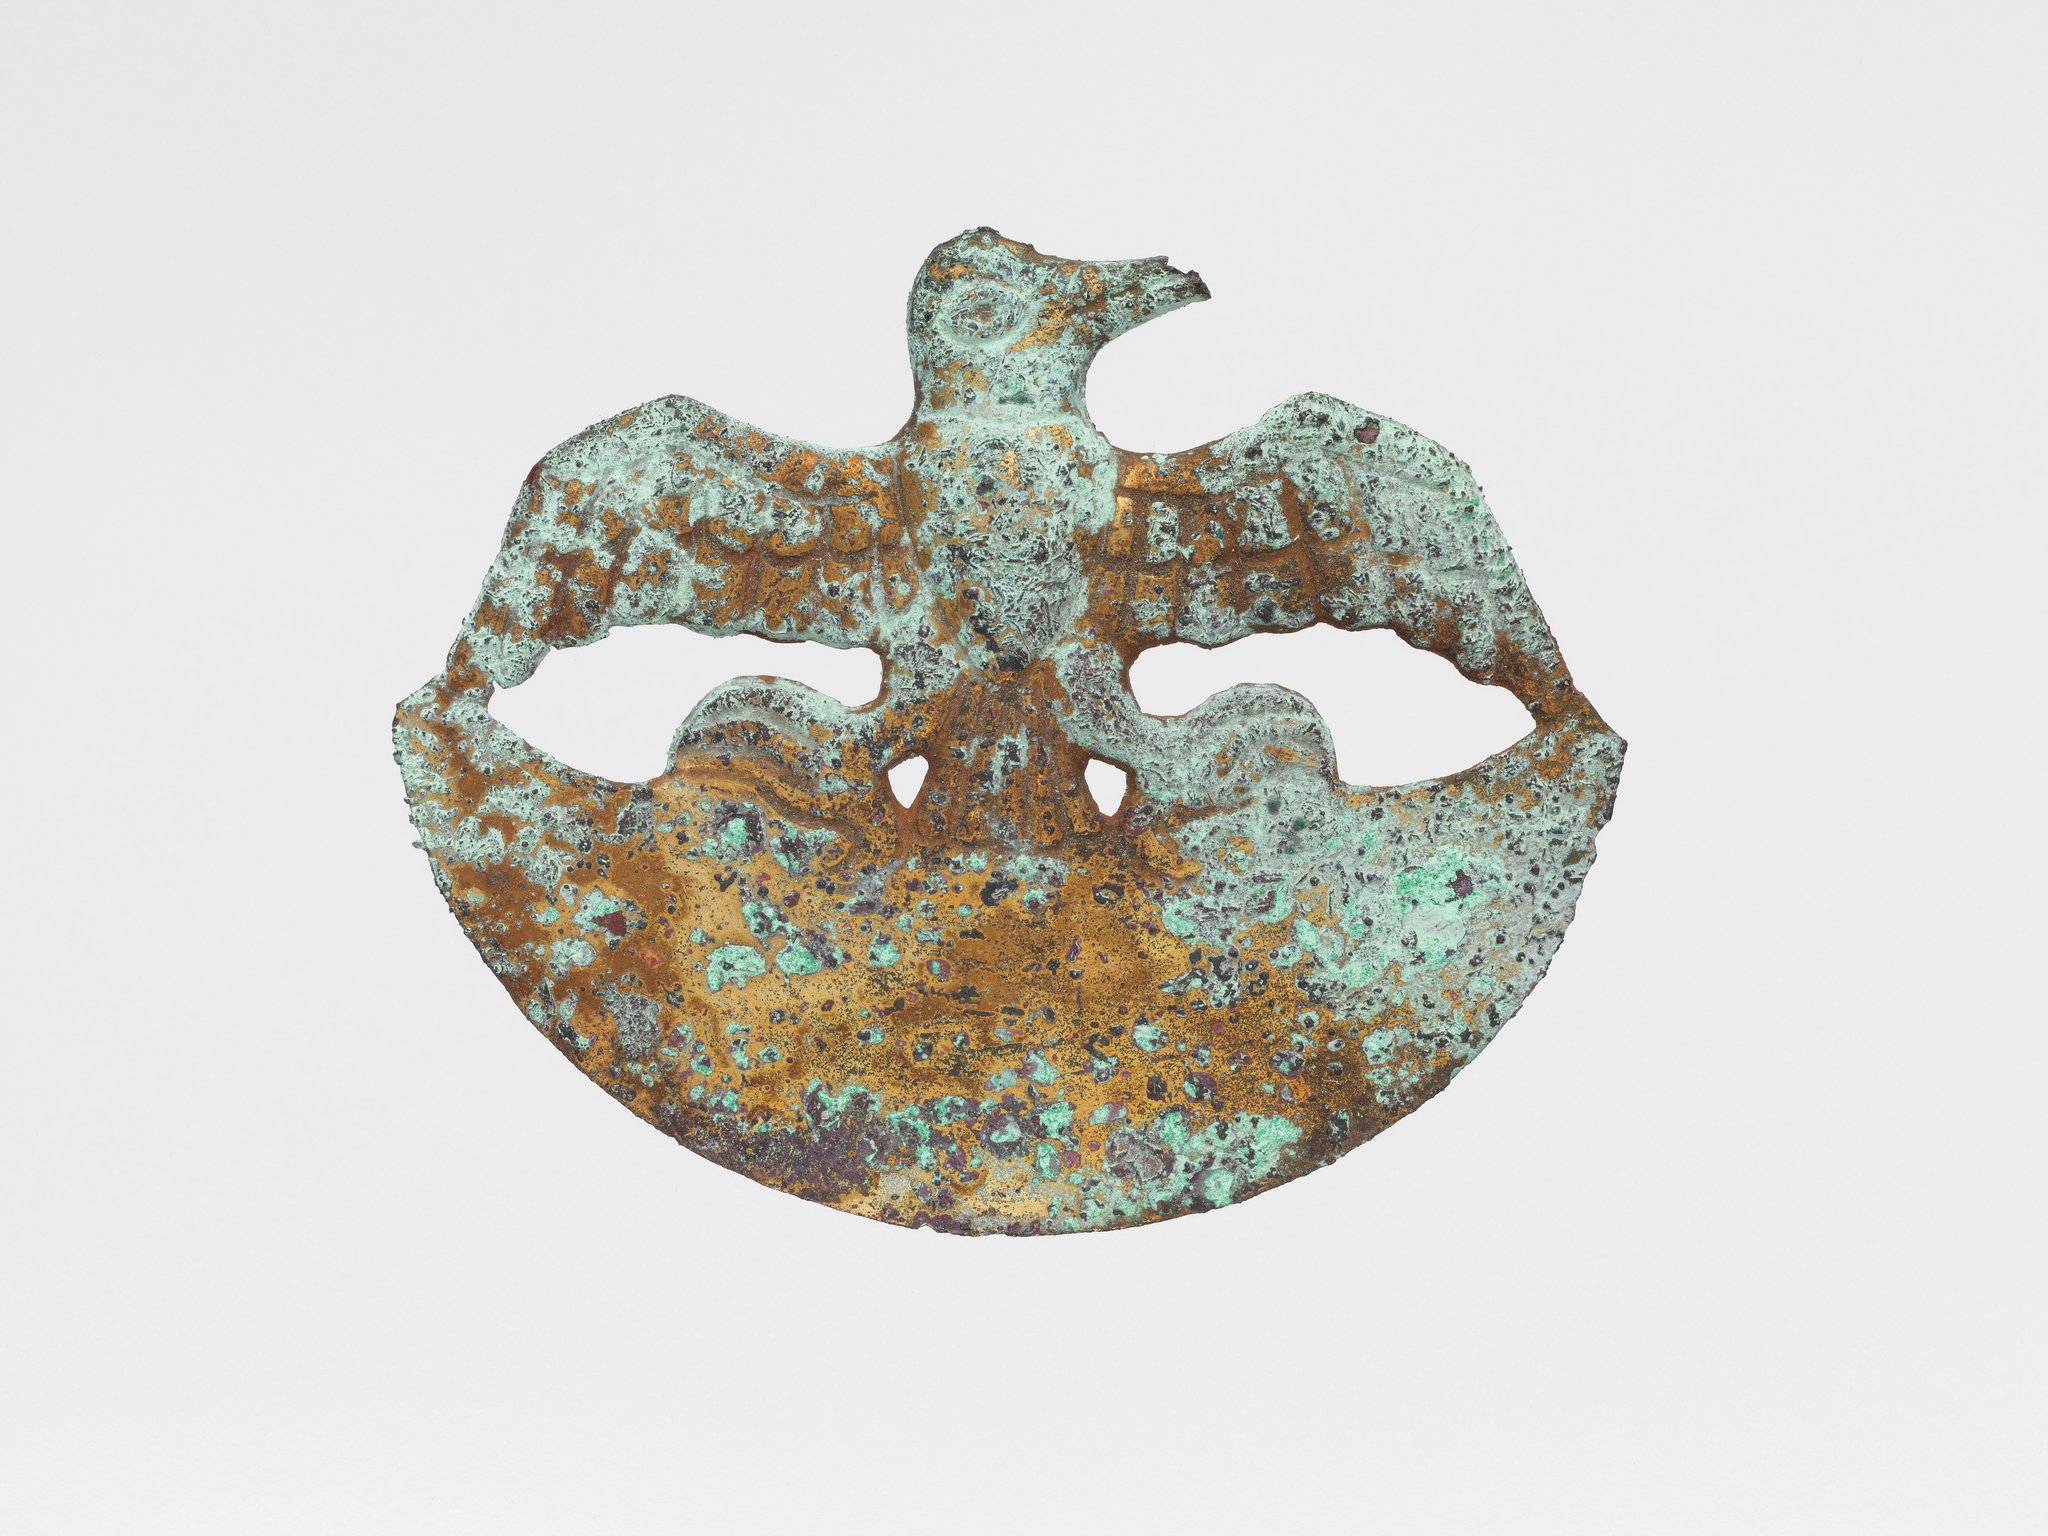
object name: ornament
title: Crescent Ornament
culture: moche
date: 501-700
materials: gilt copper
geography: peru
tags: birds